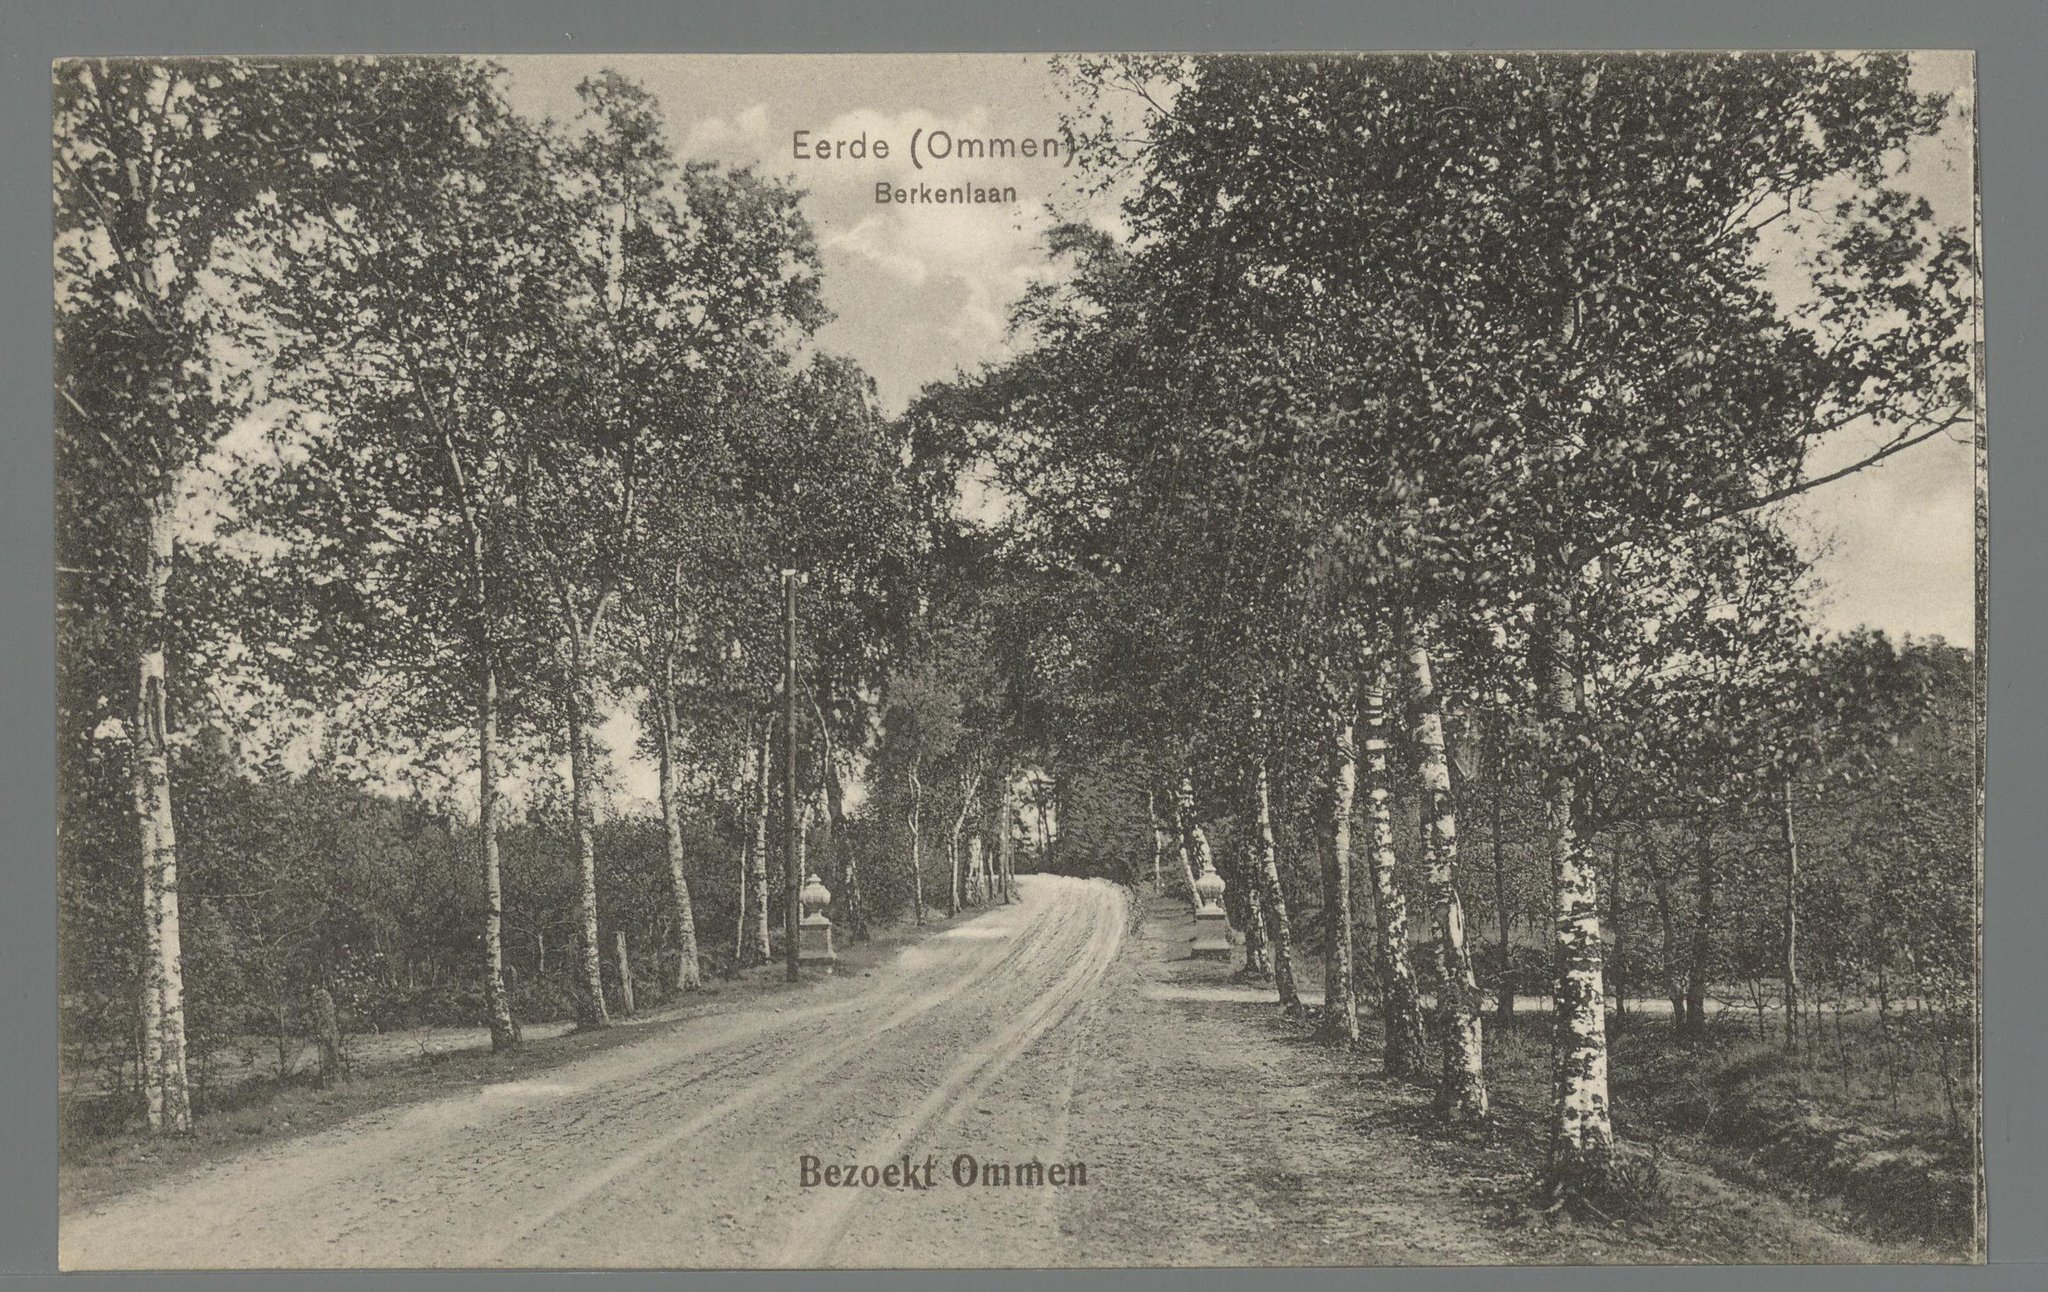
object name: ansichtkaart, prentbriefkaart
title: Eerde (Ommen). Berkenlaan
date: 1905-1913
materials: cardboard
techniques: photograph, writing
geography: ommen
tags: forest, wood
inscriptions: postage stamp